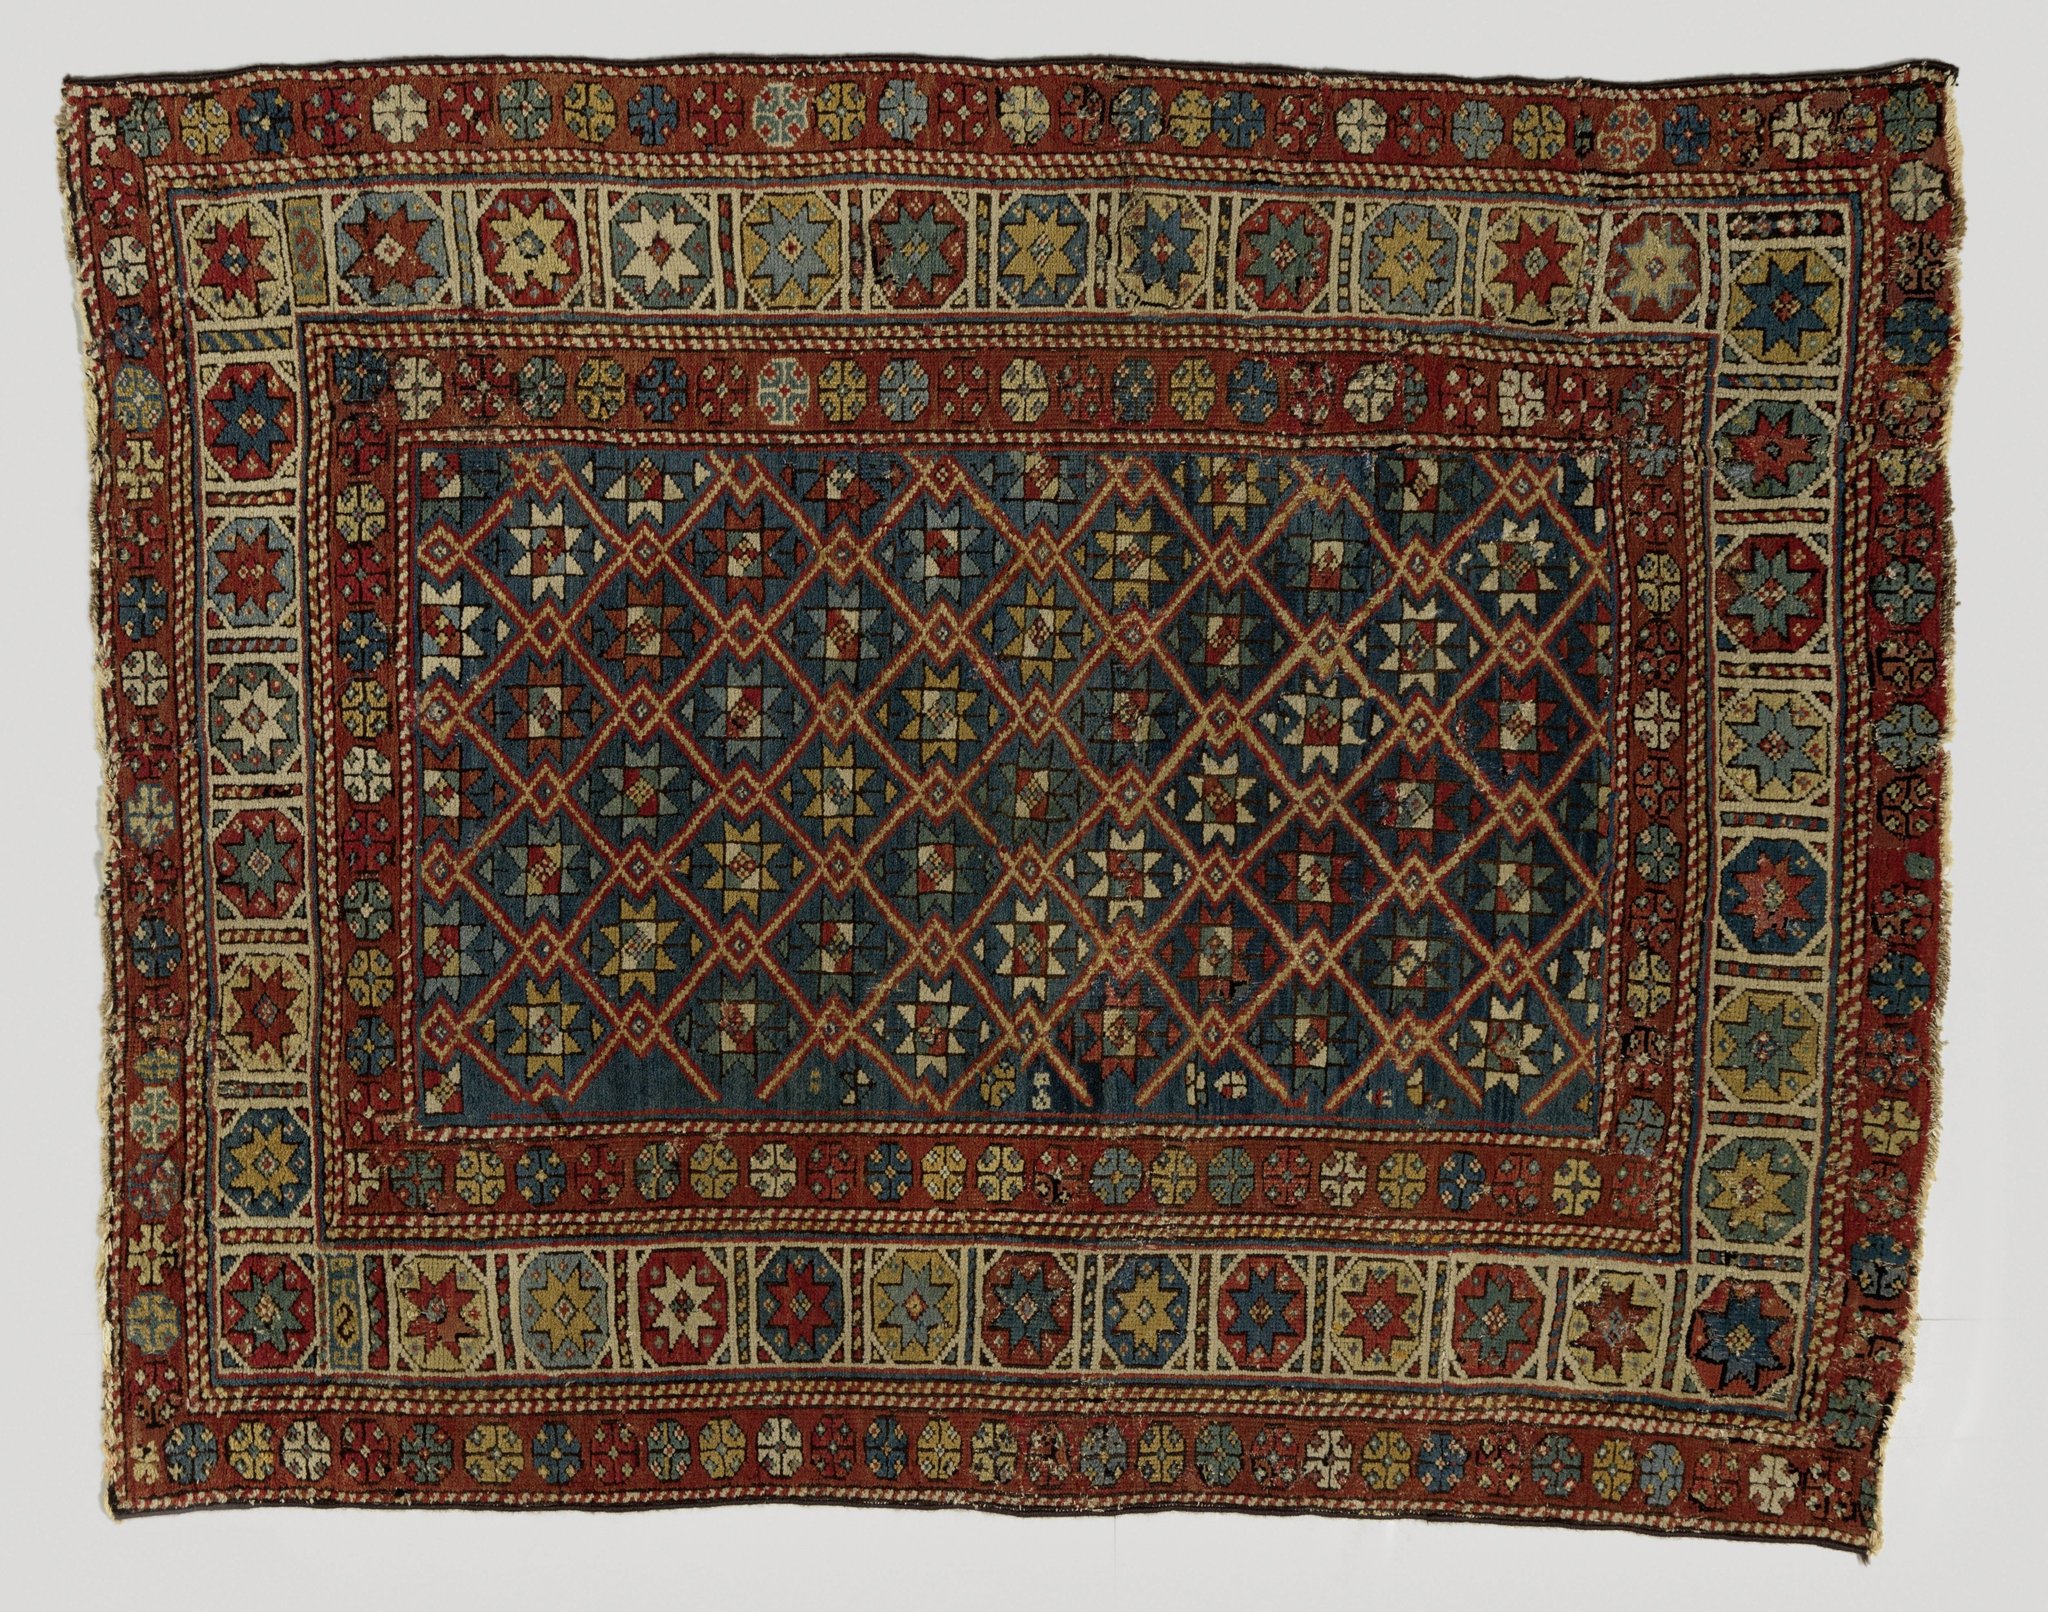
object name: oriental rug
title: Bloemenkleed, DAGHESTAN, KARABAGH of ZUID-SHIRWAN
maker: Anonymous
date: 1880-1900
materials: wool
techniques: ghiordes knot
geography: dagestan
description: Bloemenkleed, Daghestan, Karabagh of Zuid-Shirwan. Middenveld: het veld is door een rasterwerk in lichtgeel in blauwe ruiten opgedeeld waarin bruin gerande sterren staan die S-diagonaalsgewijs per kleur zijn gerangschikt in wit, turkooisgroen, rood en okergeel. Het gele raster heeft rode omtrekken en ruitjes op de knooppunten. Randen: drievoudig. De middelste en breedste is in witte vierkanten verdeeld met binnen achthoekjes staande sterren. De binnen- en buitenzomen zijn gelijk, met donkerrood fond met losse rozetbloemen.